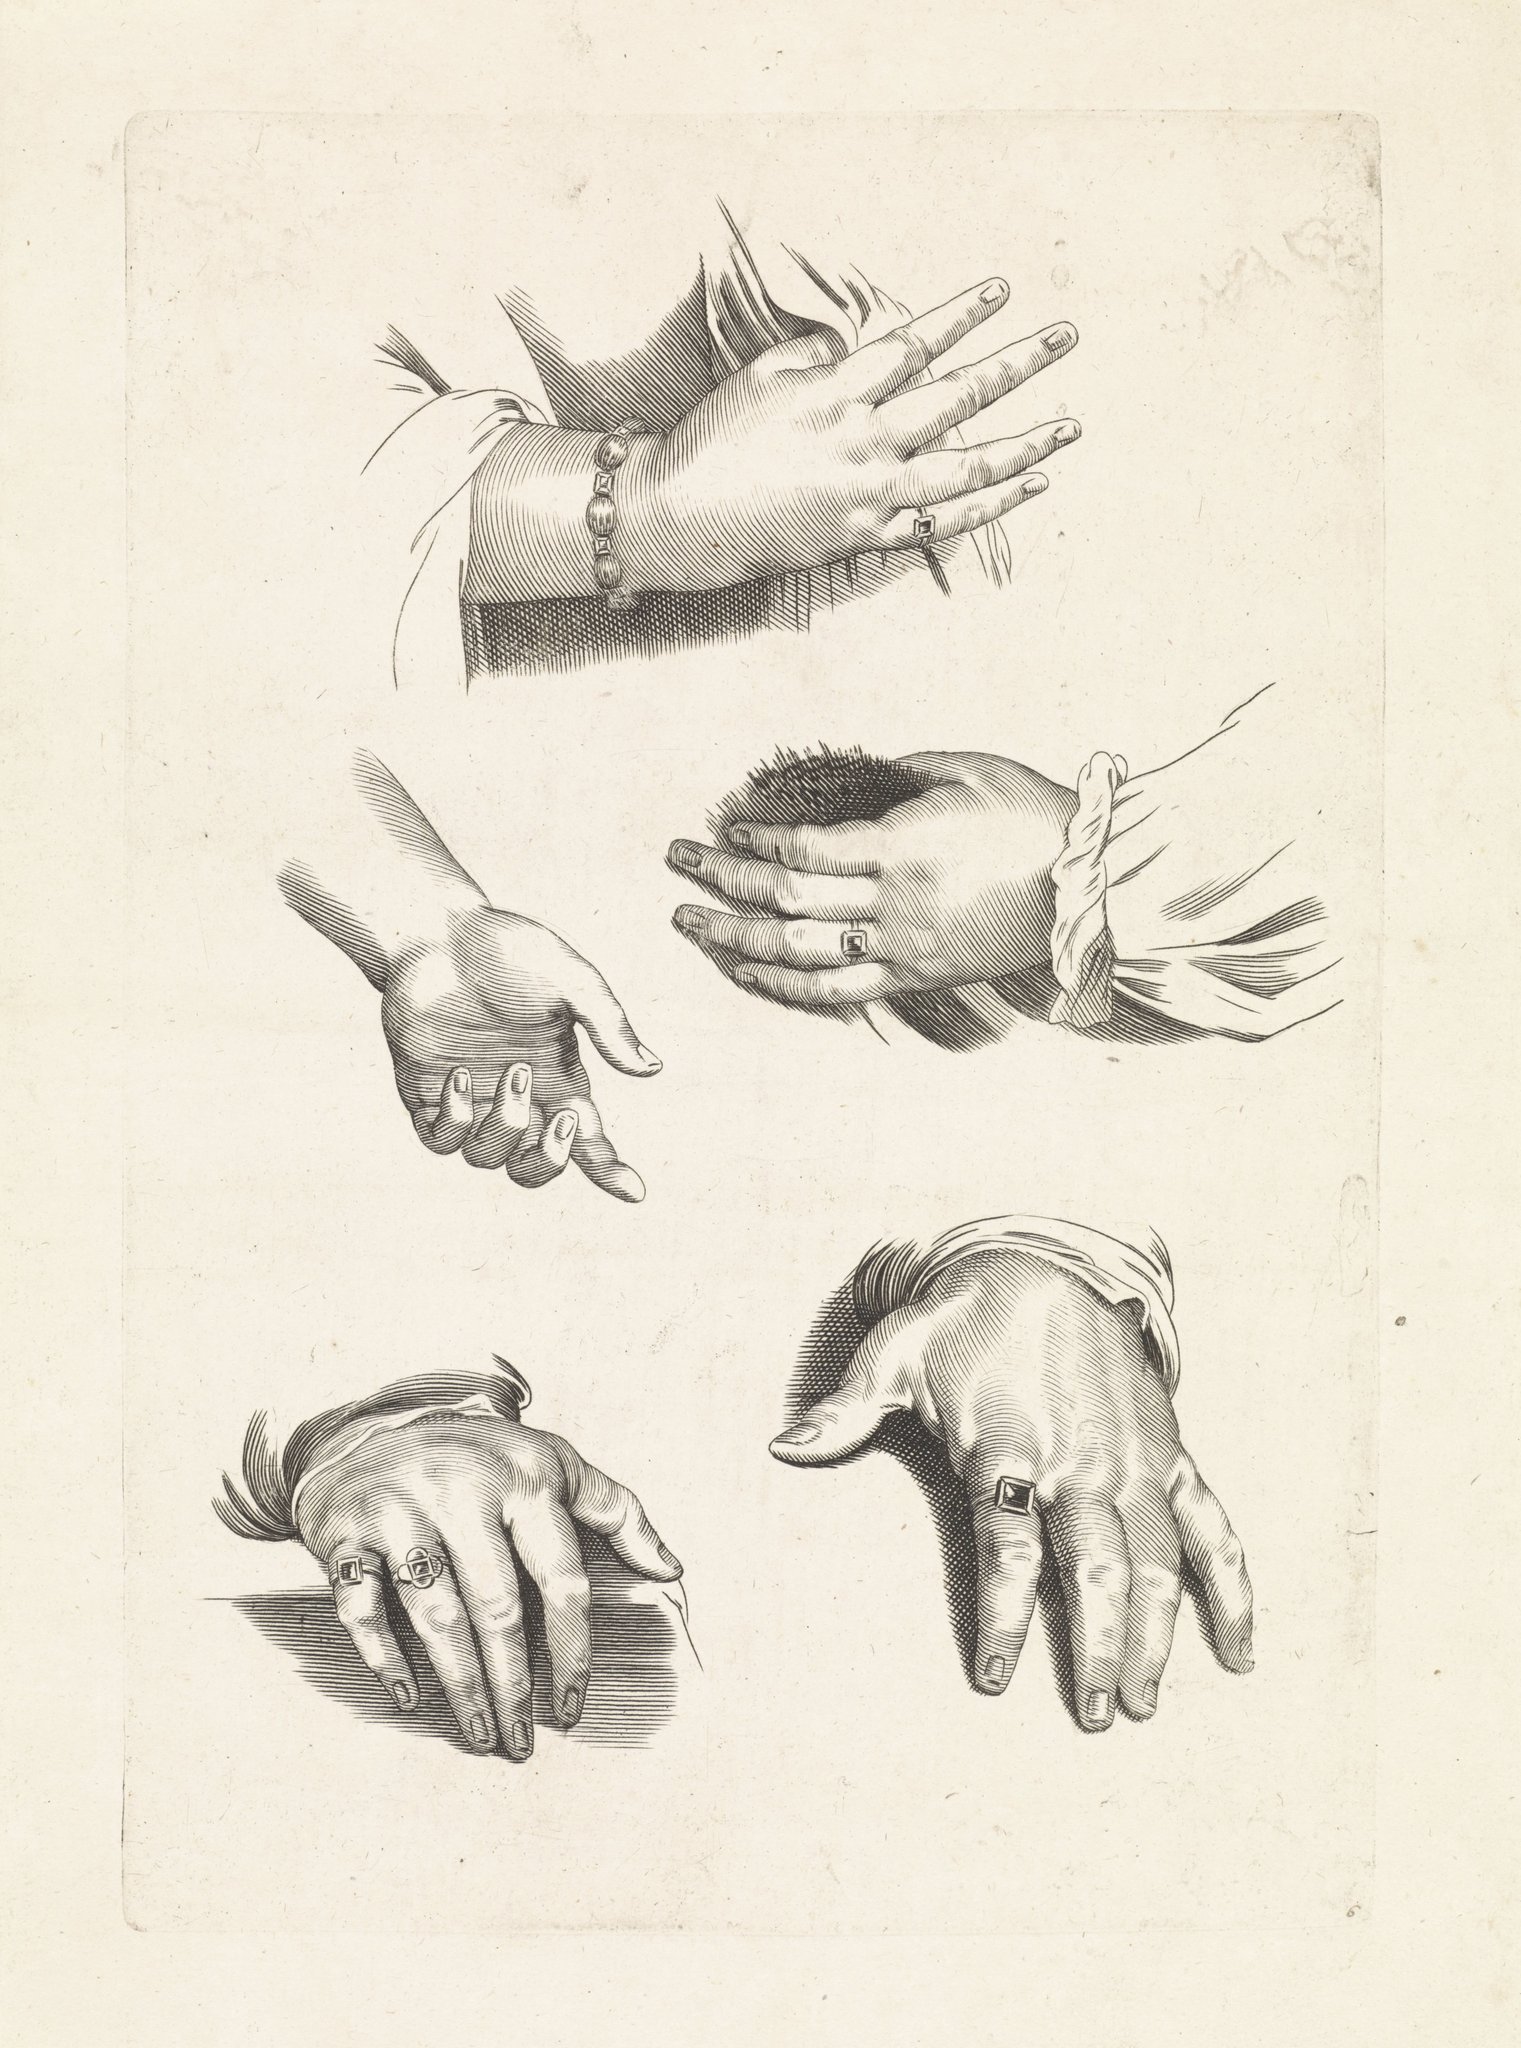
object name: print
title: Het tekenboek van Peter Paul Rubens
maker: paulus pontius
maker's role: draughtsman, print maker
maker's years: 1603-1658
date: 1616-1657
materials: paper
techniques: engraving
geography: antwerp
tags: hand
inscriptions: number: ‘6’, collector's mark: Lugt 240